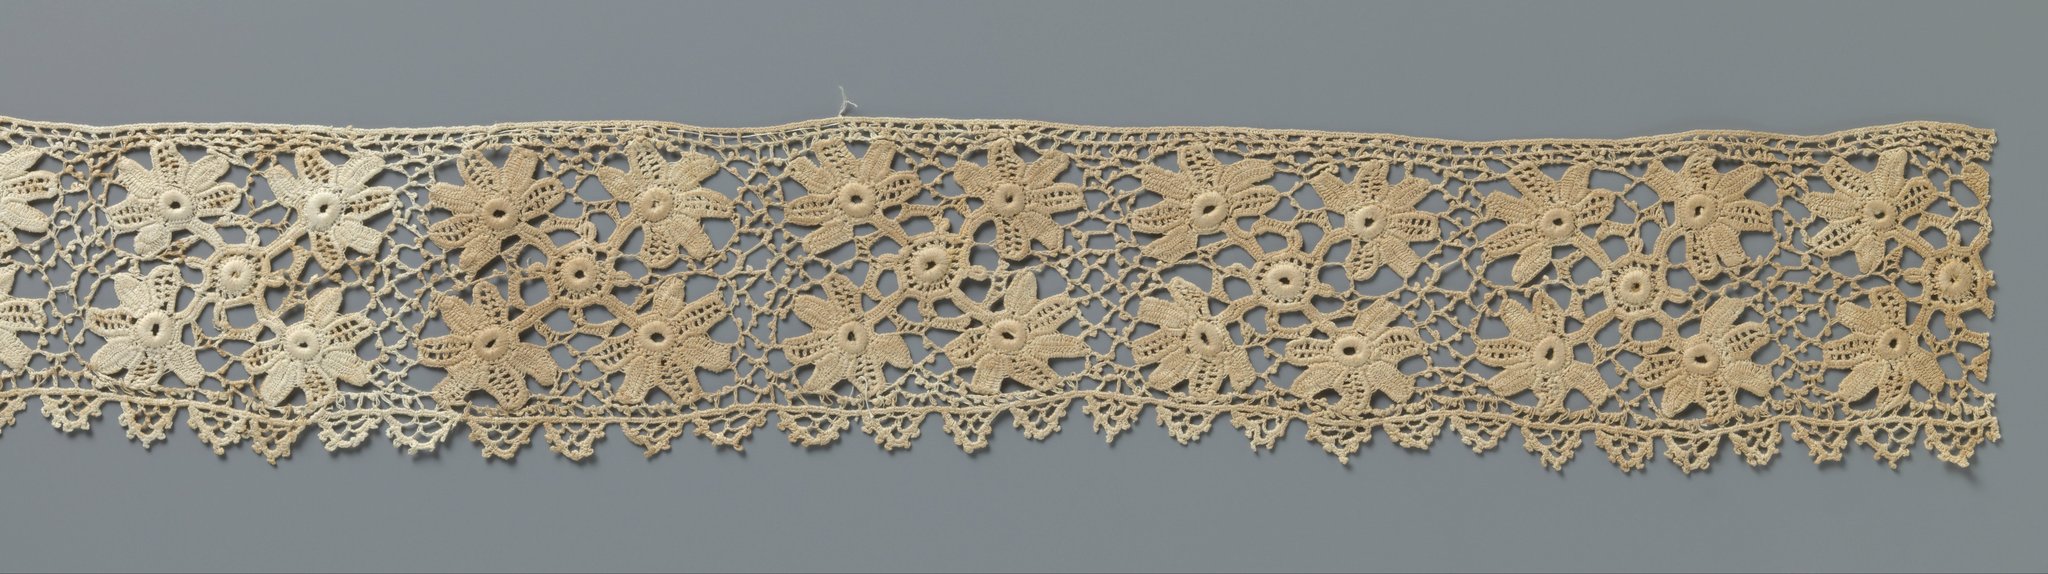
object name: strip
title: Strook gehaakte kant met vier bloemen rondom een cirkel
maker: Anonymous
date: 1890-1909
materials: cotton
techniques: crocheted lace, irish crochet lace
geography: ireland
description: Het is een aanname dat deze Ierse gehaakte kant ook daadwerkelijk in Ierland is gemaakt. Ierse gehaakte kant kent zijn oorsprong rond 1760 en kwam vanaf 1840 in ontwikkeling. Aangezien volgens Martine Bruggeman (Kant in Europa) de Ierse haakindustrie aan het eind van de 19e eeuw gereorganiseerd werd en in populariteit groeide, is het hier beschreven stuk gedateerd rond 1890, tot 1909 vanwege de datering in het eerste decennium van populariteit van Ierse gehaakte kant volgens het Kantlexicon (Johan Coene).